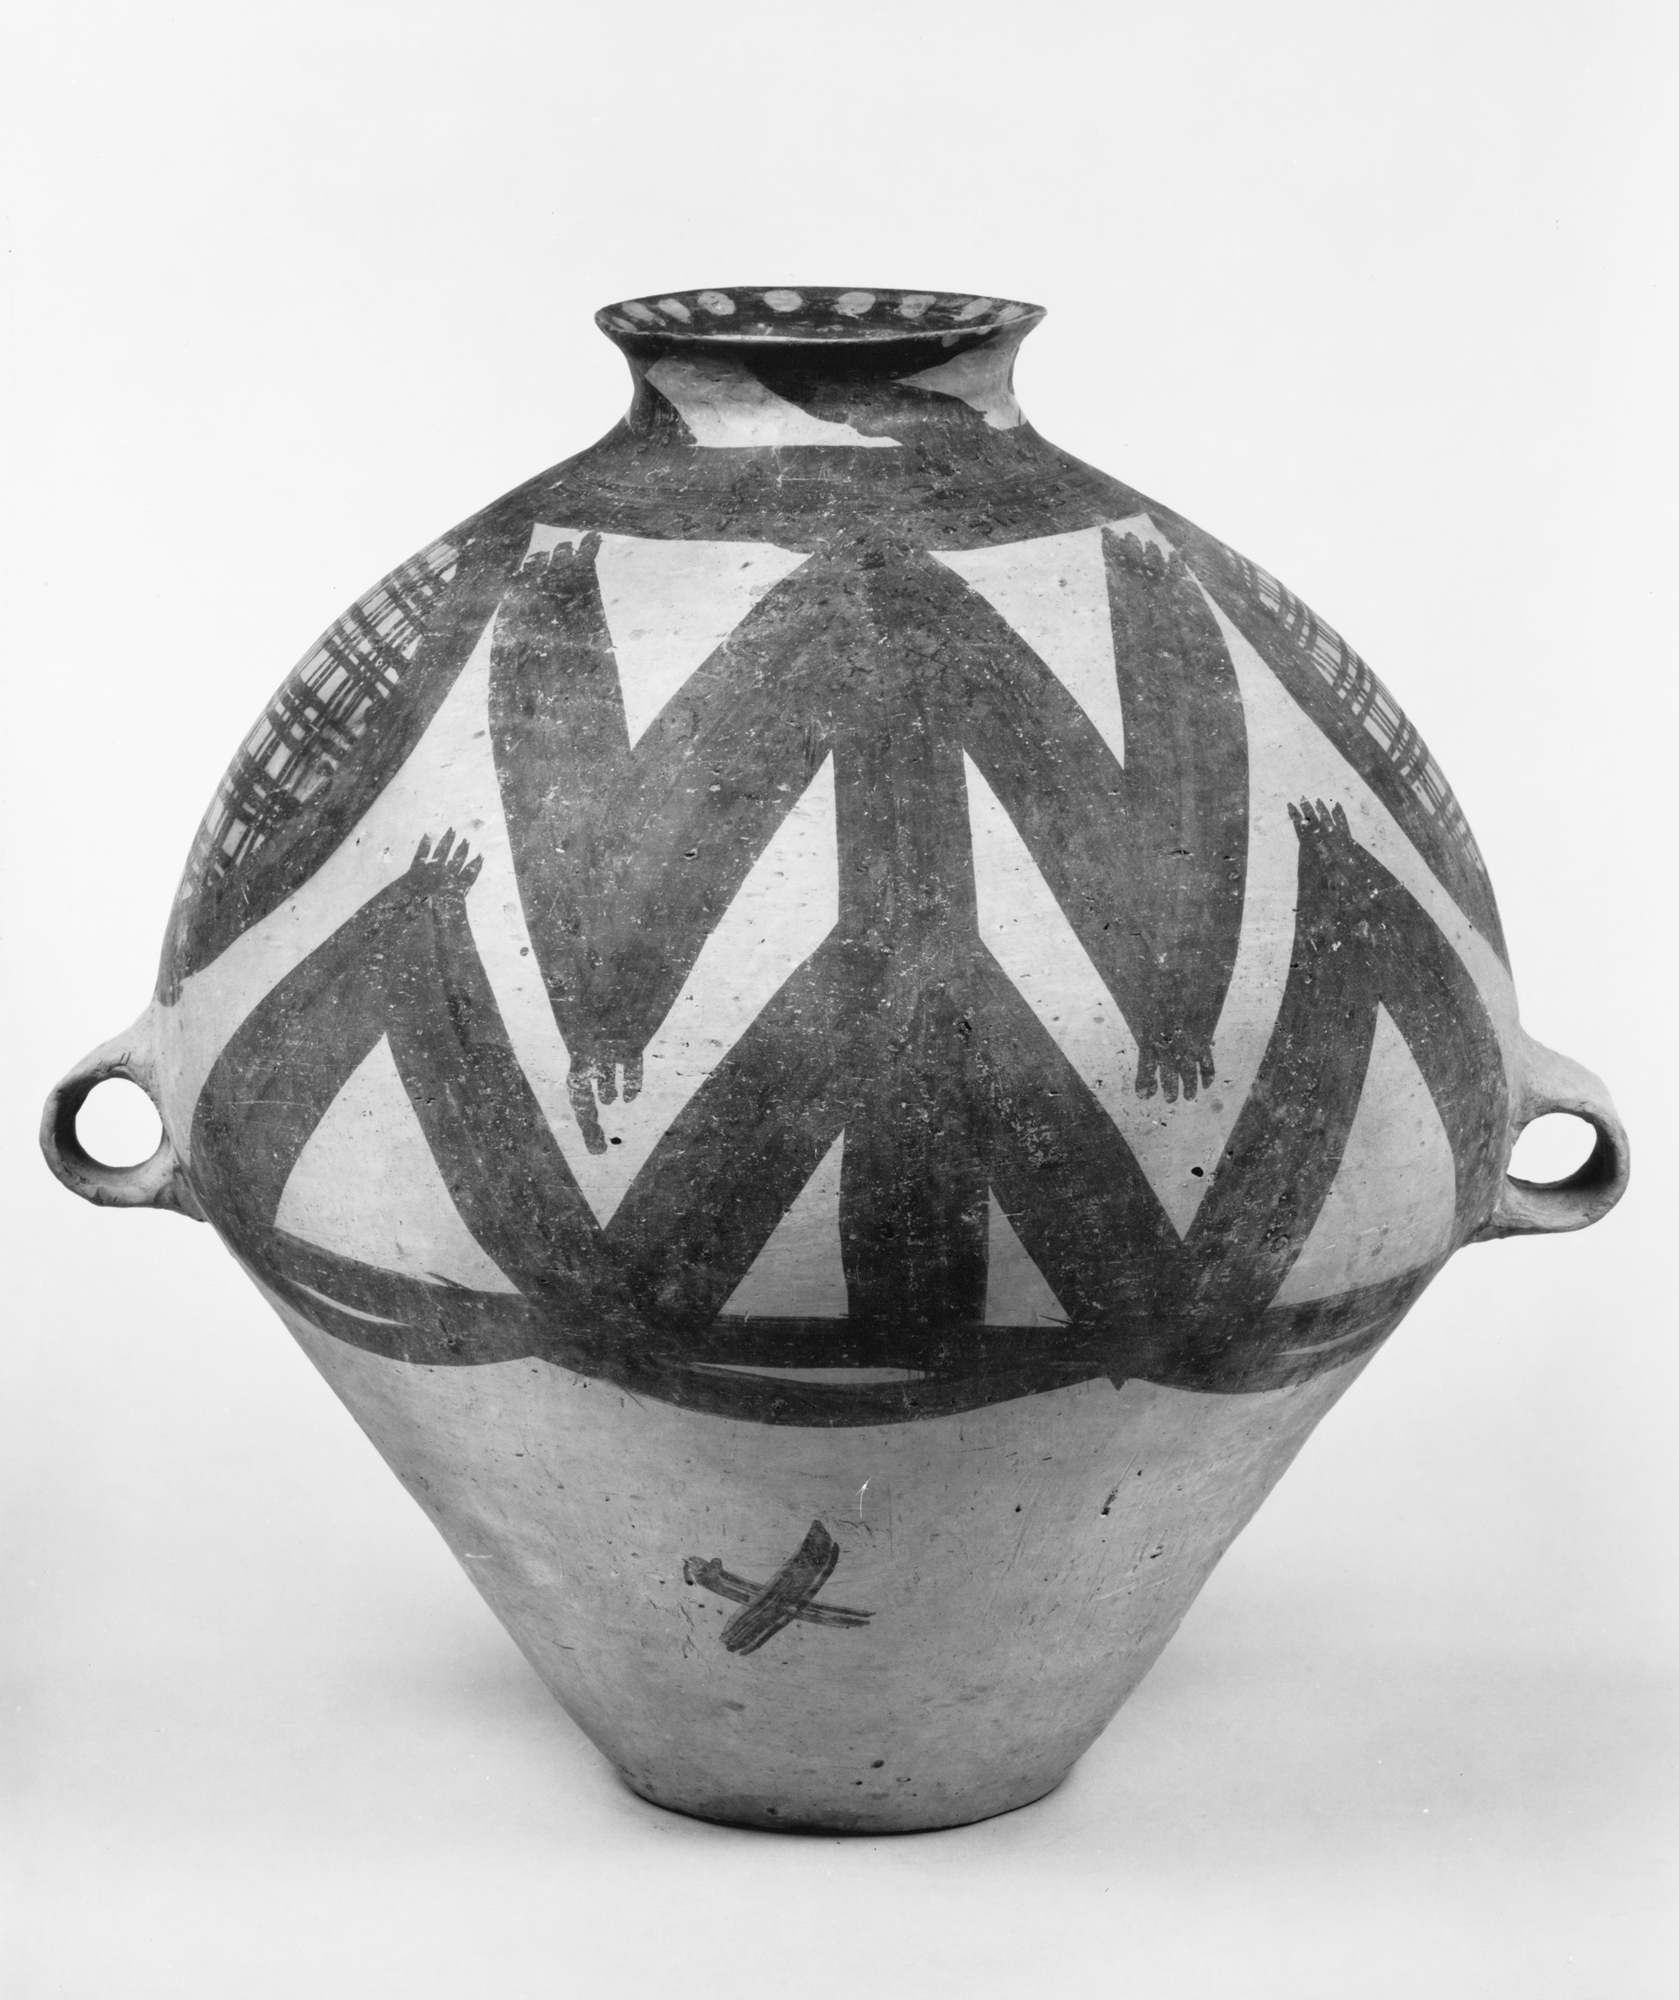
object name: jar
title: Jar (Guan)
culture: chinese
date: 2300-2000 BCE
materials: earthenware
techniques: painting